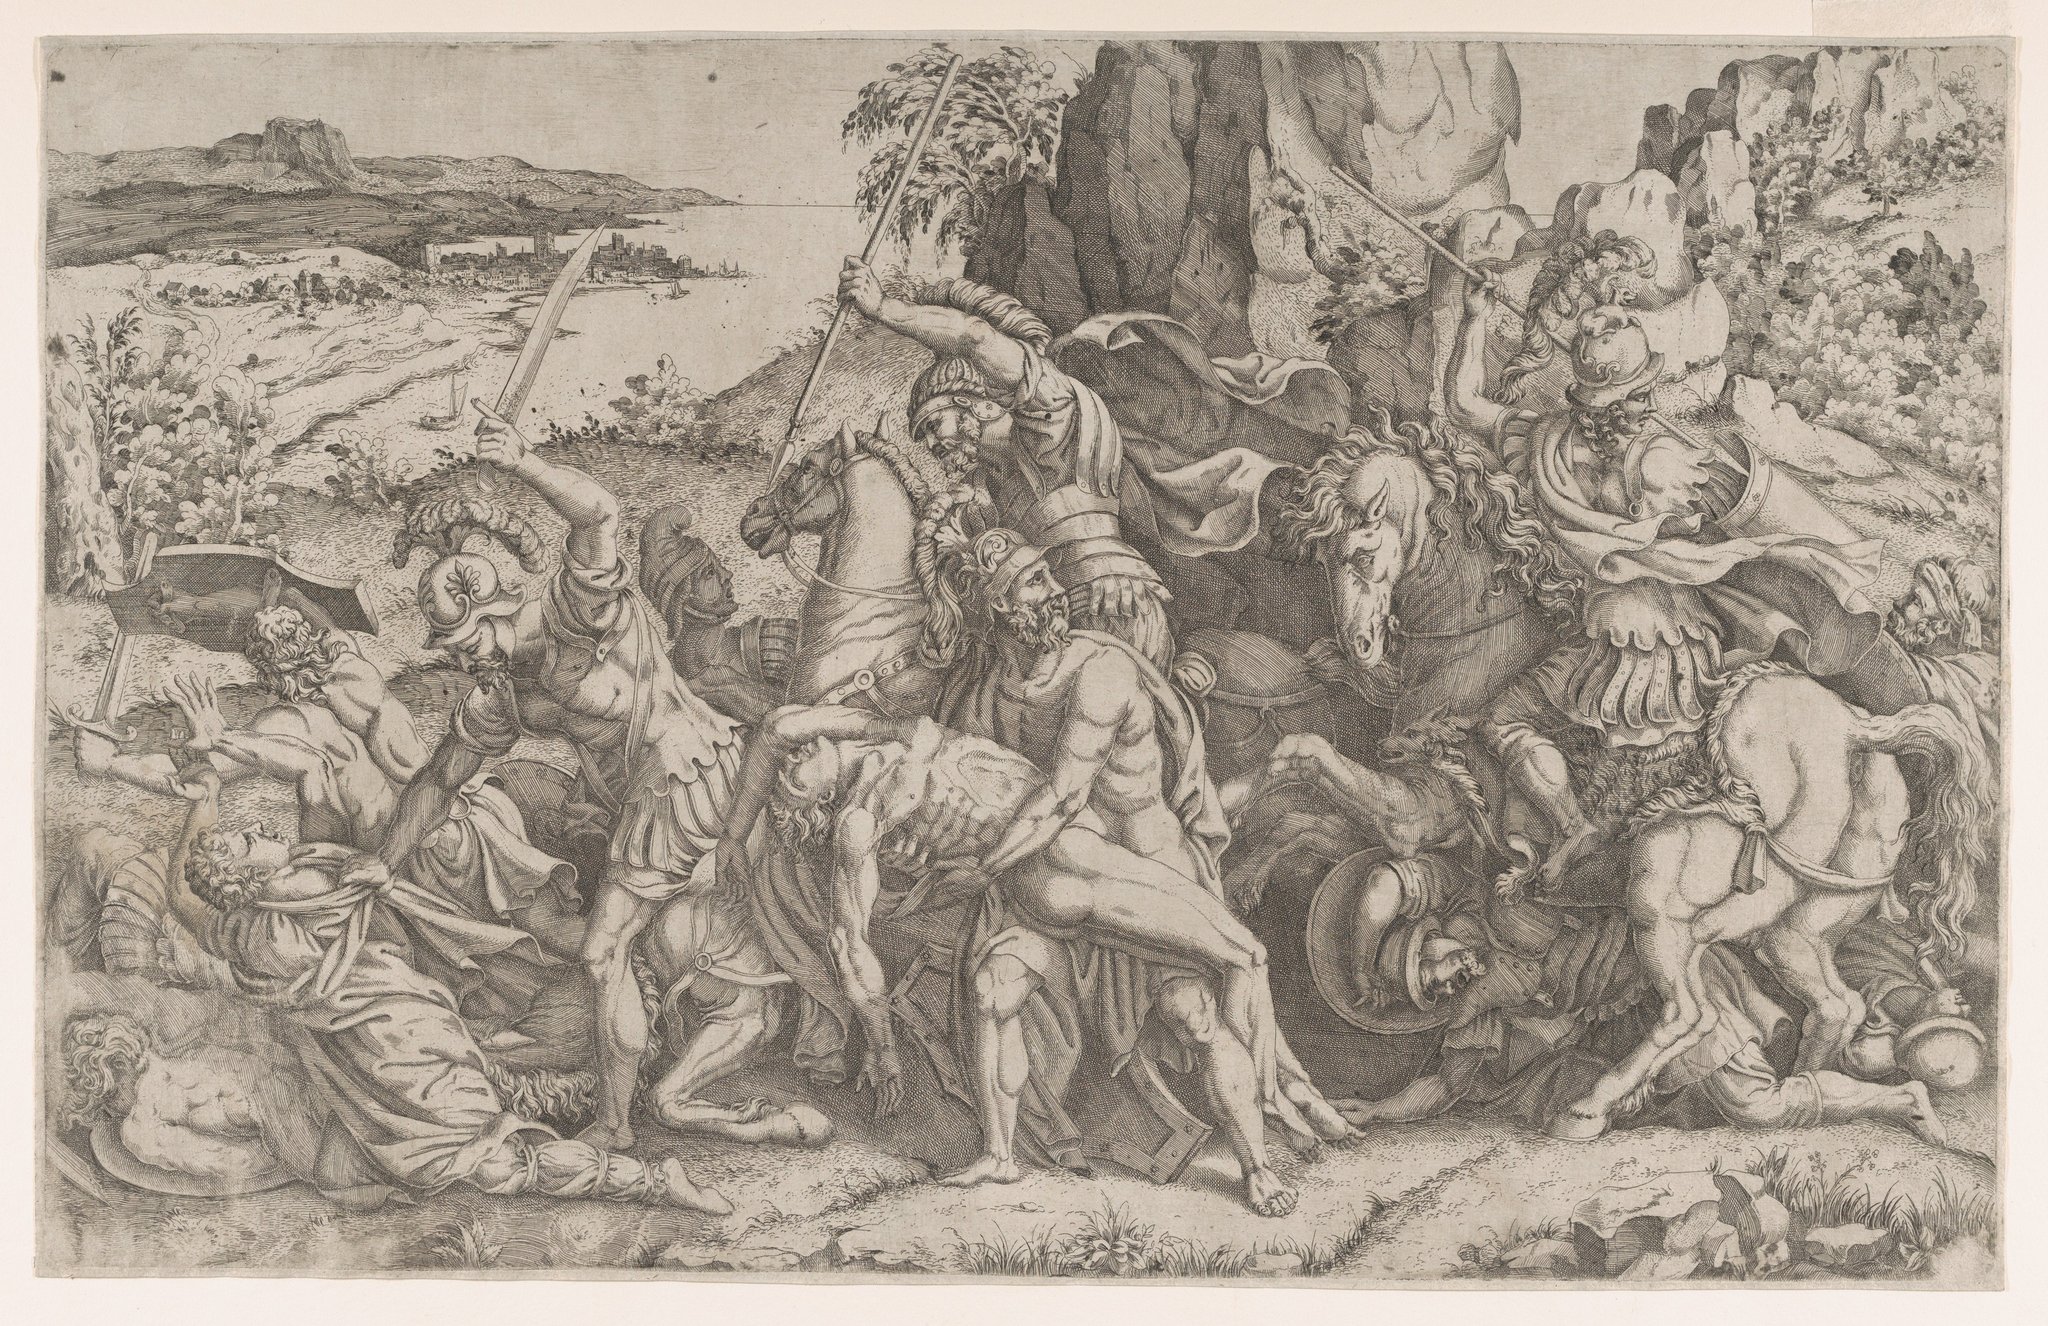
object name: print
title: Battle around the Body of Patroclus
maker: anonymous, school of fontainebleau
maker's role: artist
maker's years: 1500-1600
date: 1543-1547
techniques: etching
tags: battles,men,patroclus